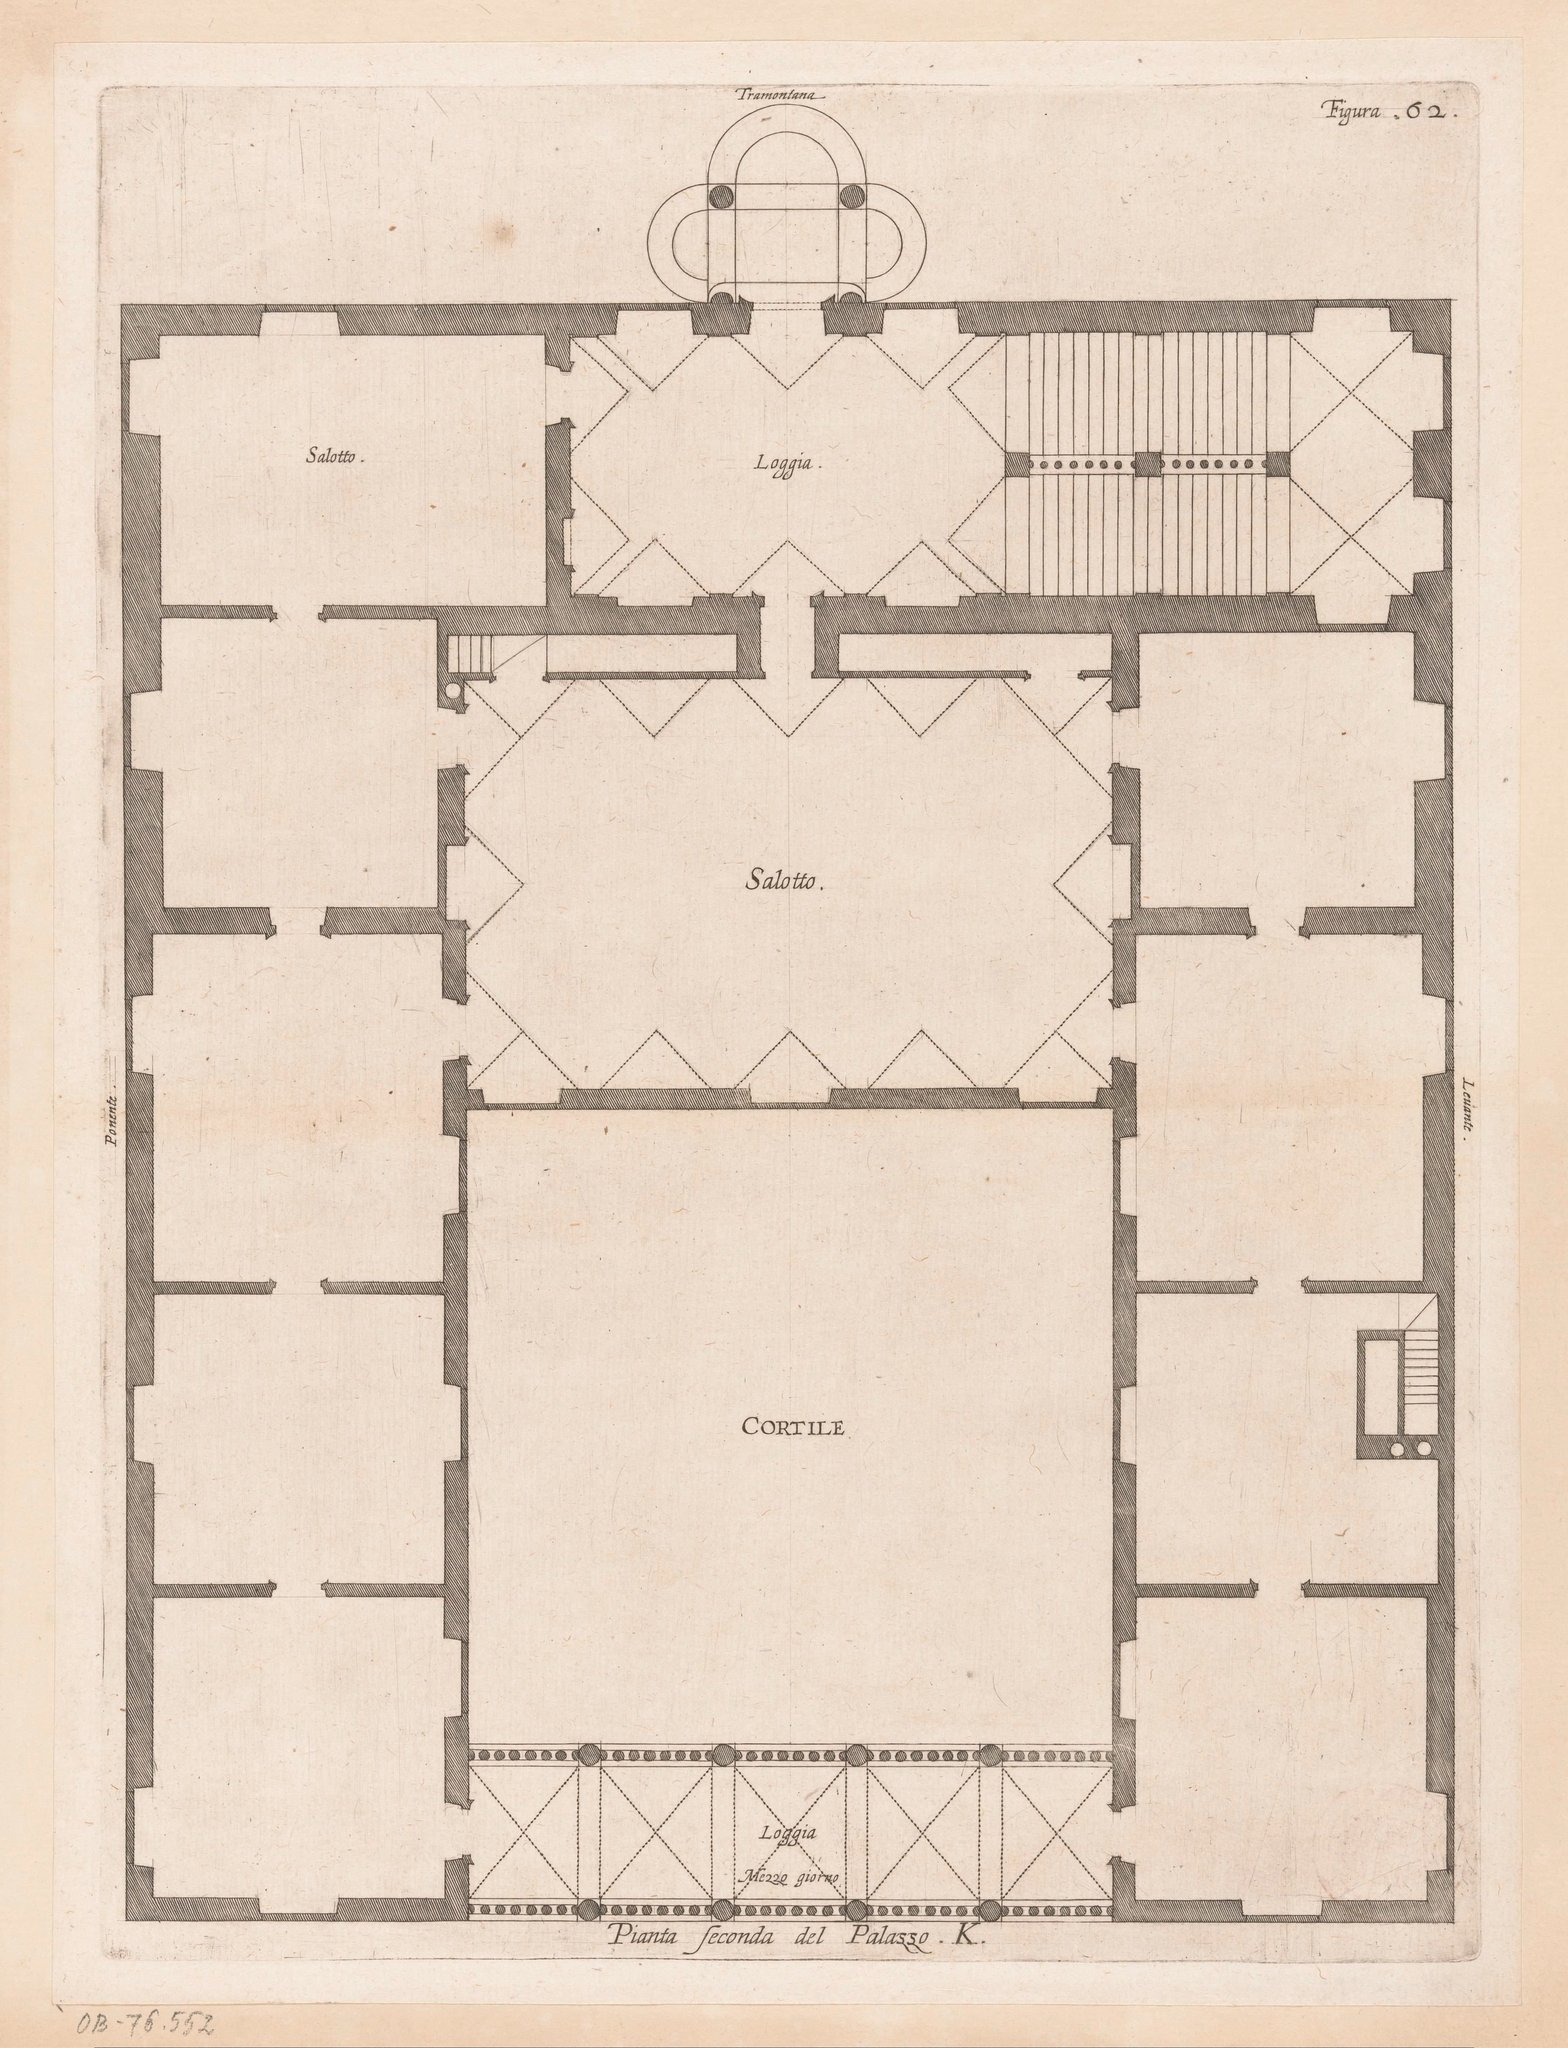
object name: print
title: Palazzi di Genova / Palazzi Antichi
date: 1622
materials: paper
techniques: engraving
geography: antwerp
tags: hôtel, i.e. small palace in city - aa - civic architecture: inside, plan ~ architecture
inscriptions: collector's mark: Lugt 240